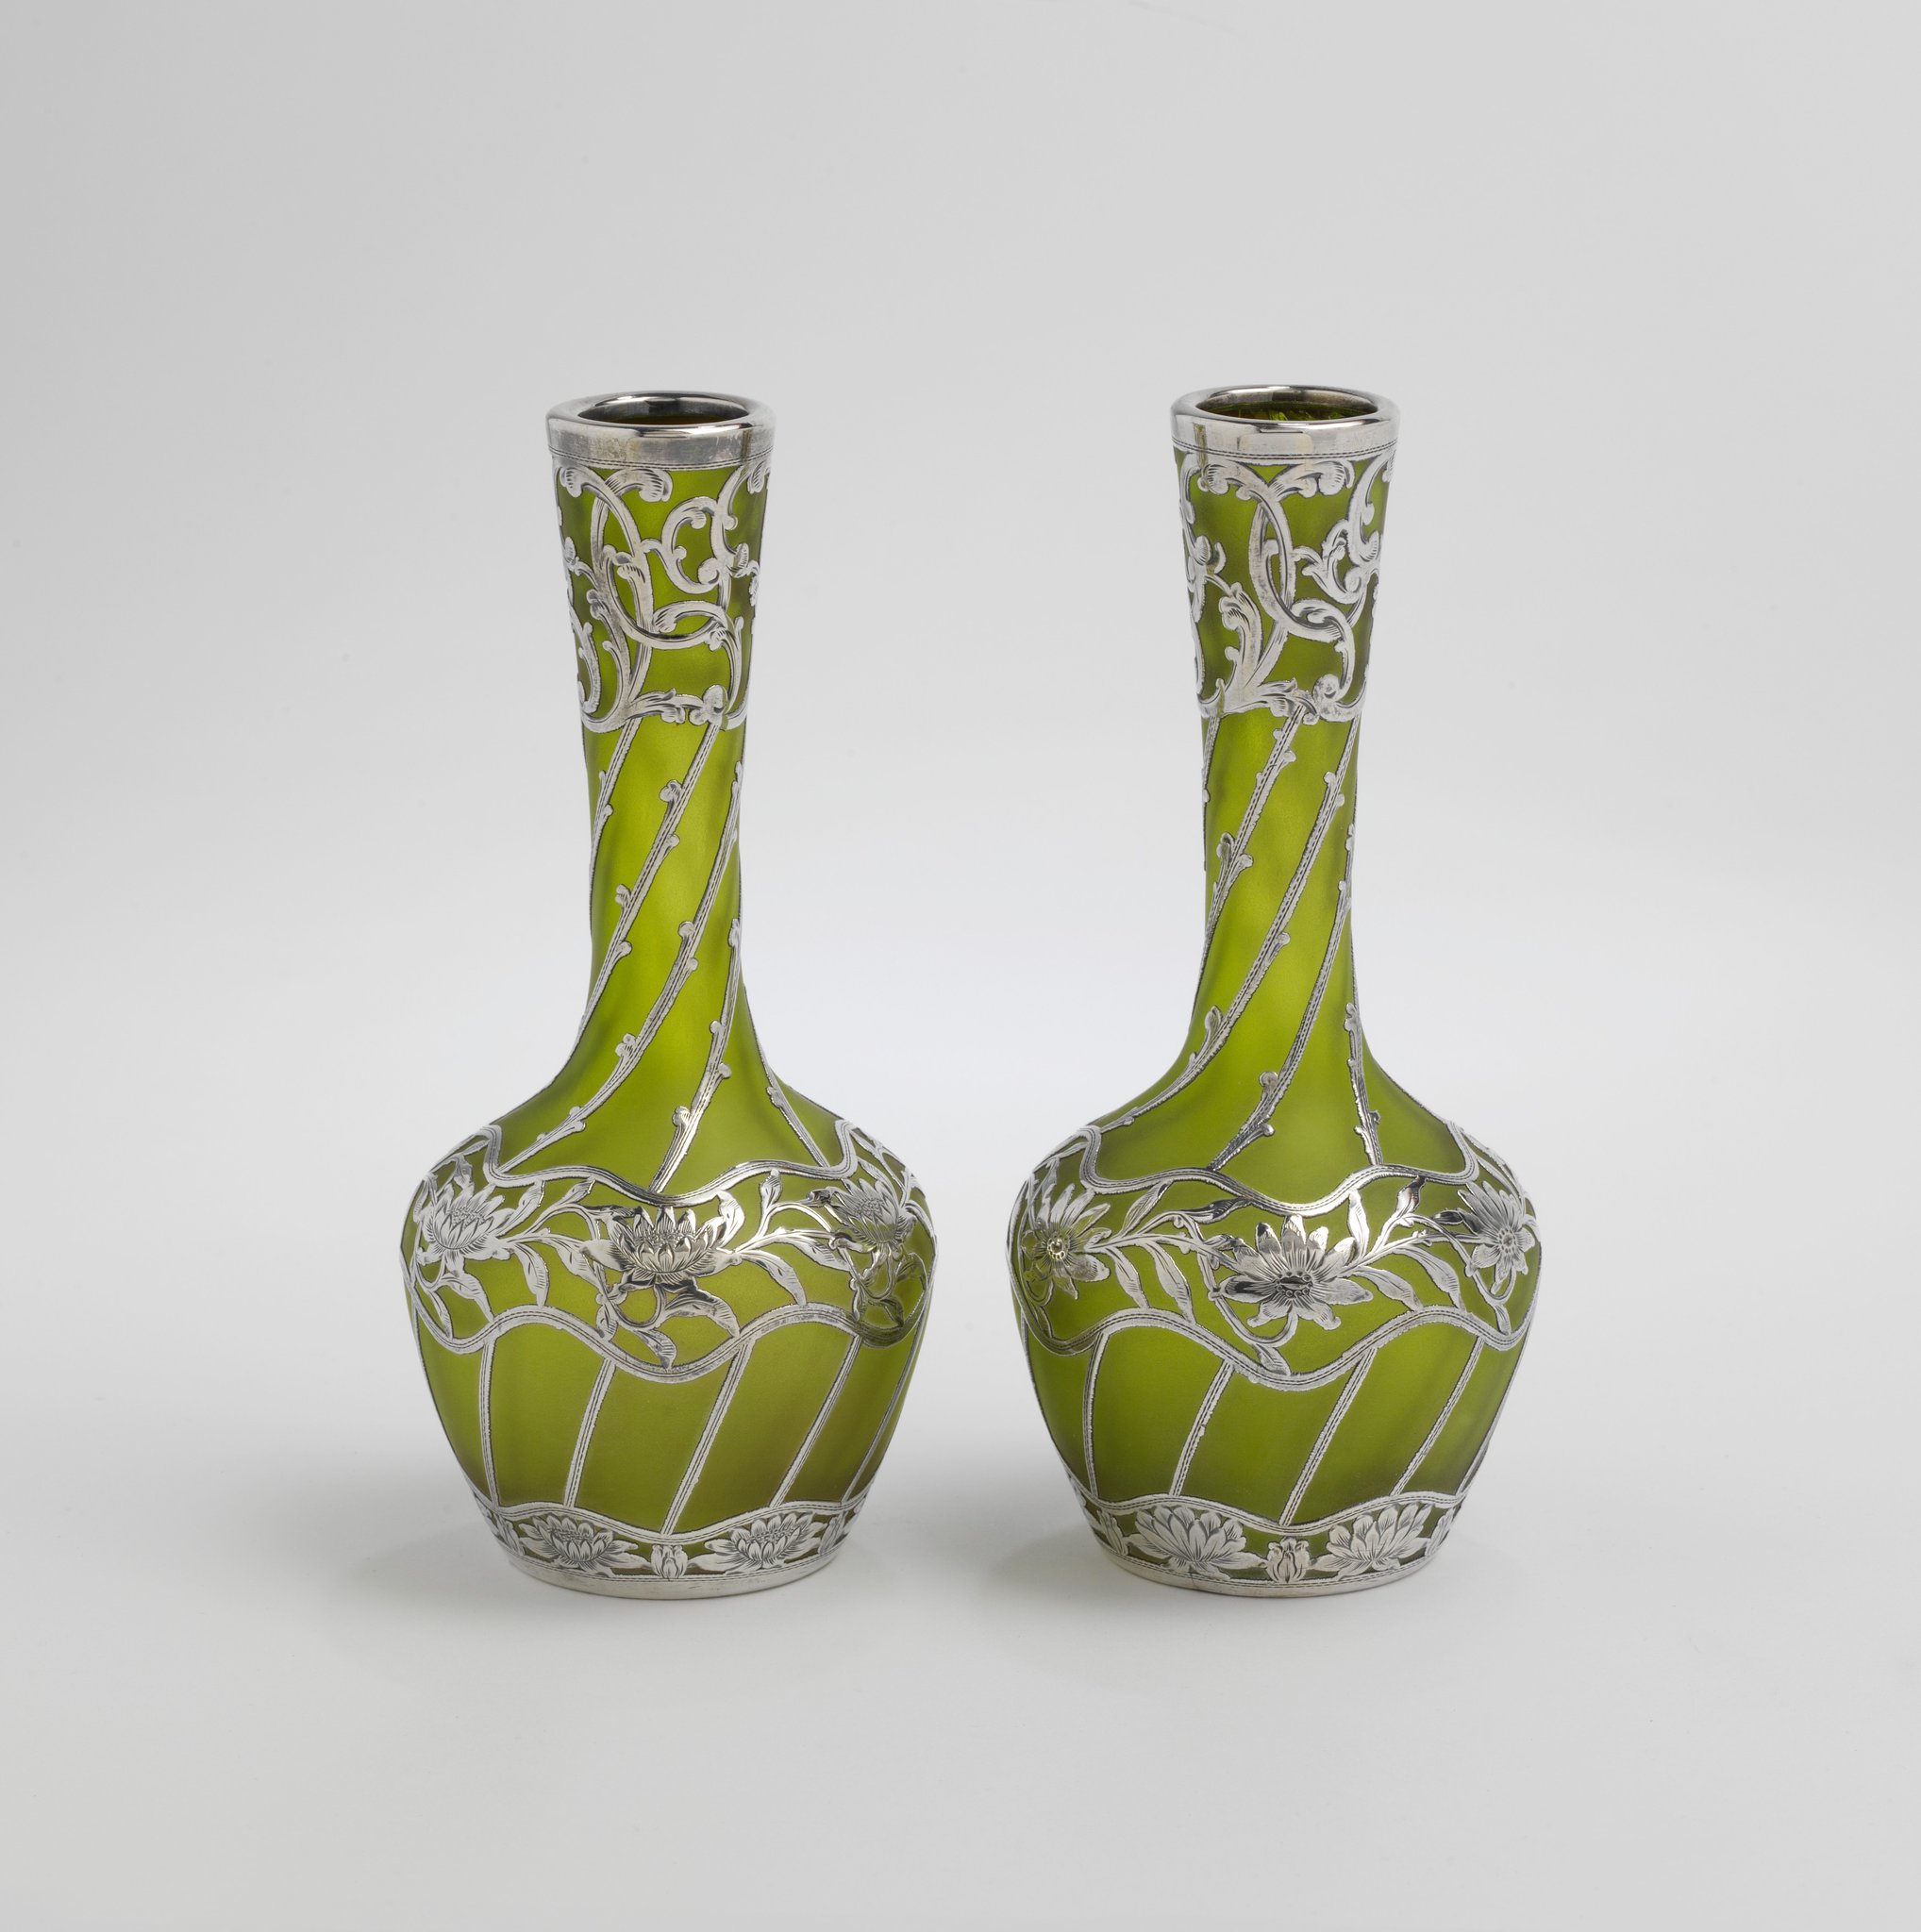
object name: vase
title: Pair of vases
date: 1895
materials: glass, silver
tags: flowers